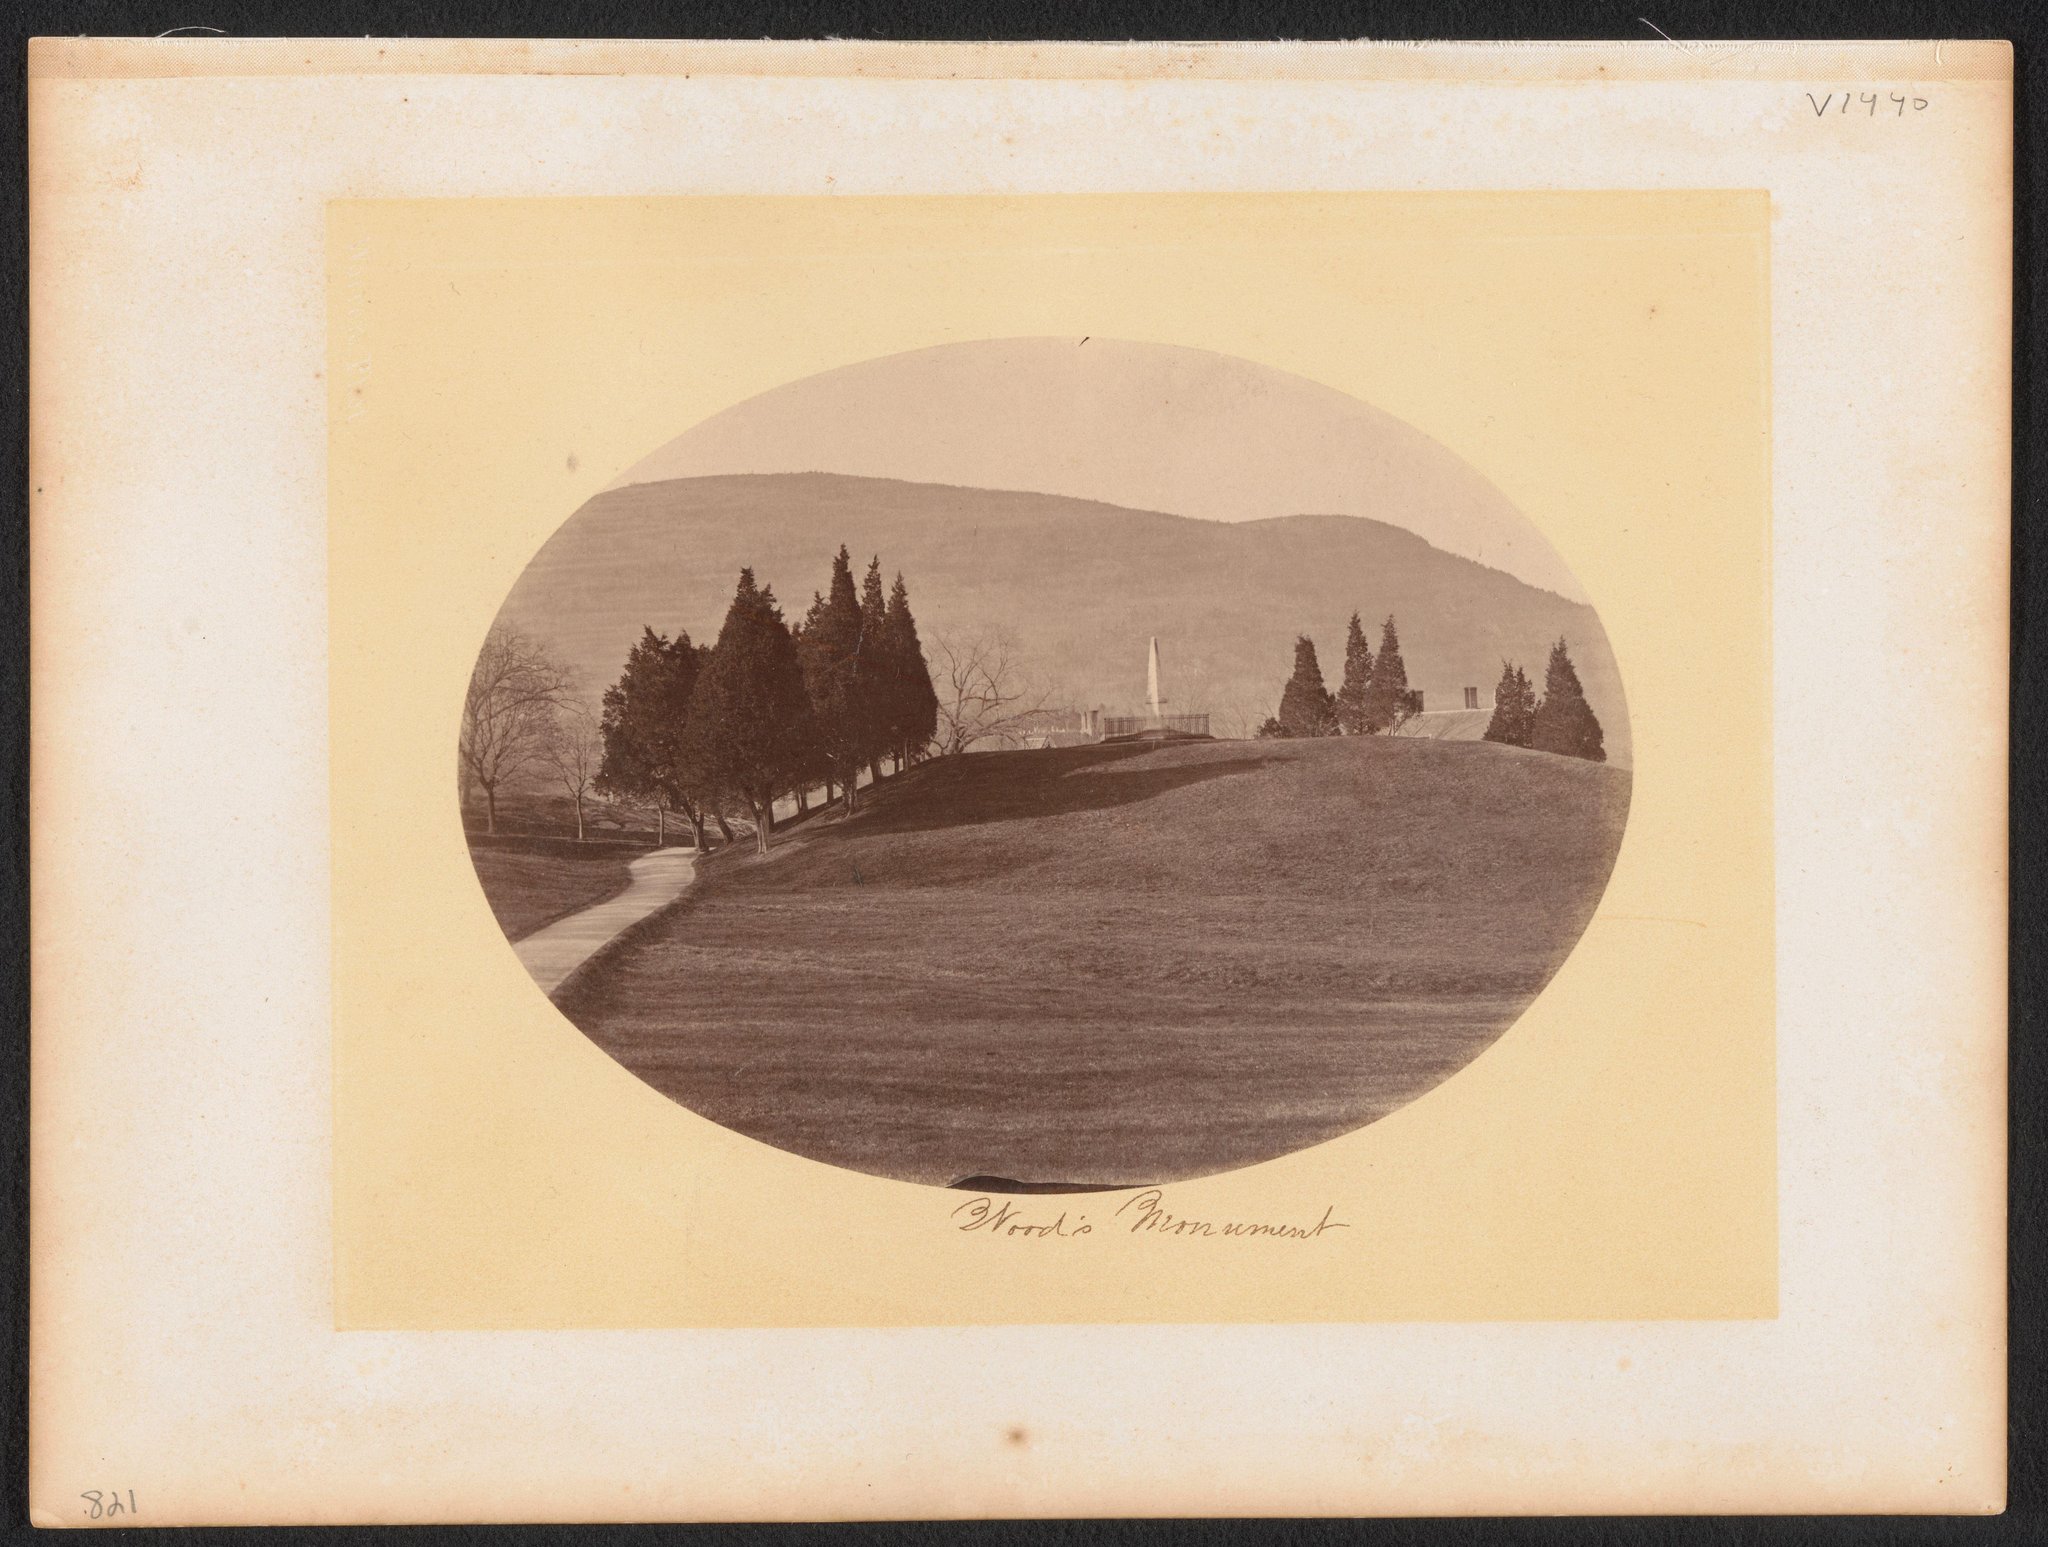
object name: photograph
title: Gezicht op Wood's Monument, West Point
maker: george kendall warren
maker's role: fotograaf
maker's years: 1833-1884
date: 1867-1868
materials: cardboard, paper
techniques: albumen print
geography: west point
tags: obelisk, needle, landscape with monument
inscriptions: inscription: ‘Wood's Monument’, inscription: ‘Warren Phot.’